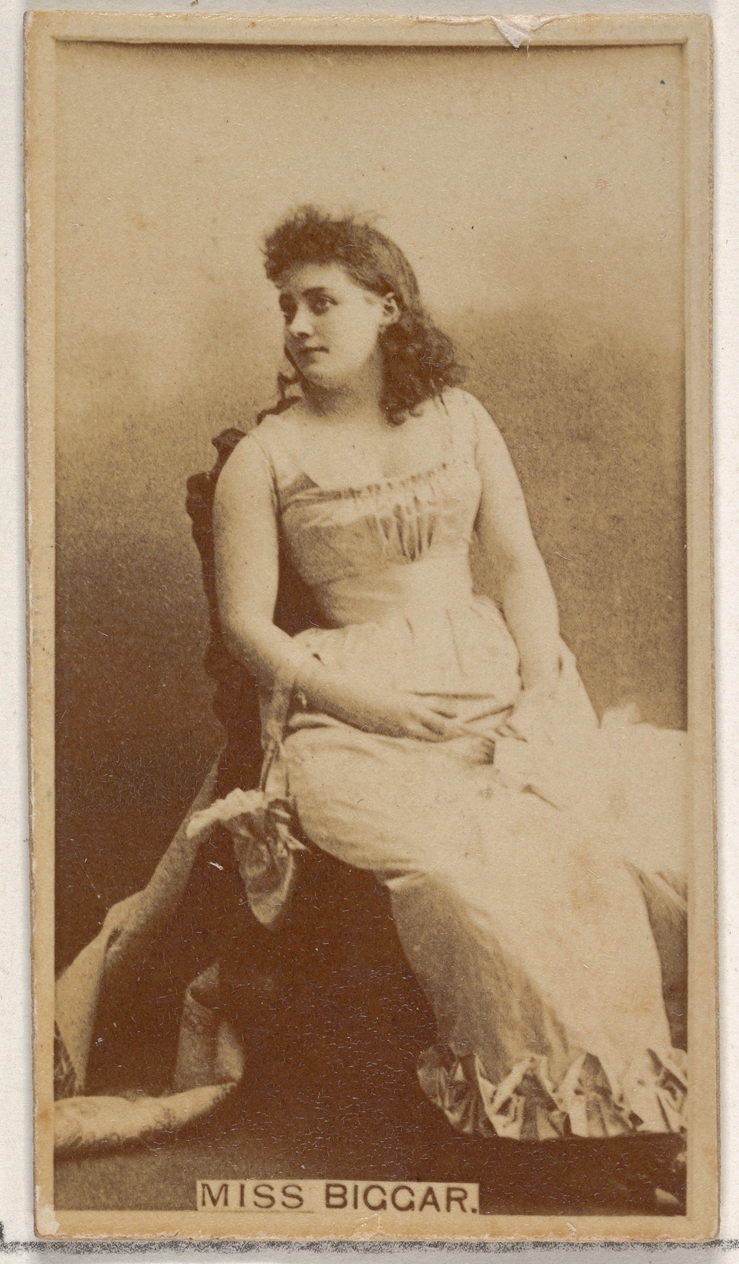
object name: photograph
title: Miss Laura Biggar, from the Actors and Actresses series (N45, Type 8) for Virginia Brights Cigarettes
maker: allen & ginter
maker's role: publisher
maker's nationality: american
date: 1888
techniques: albumen silver print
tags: portraits,women,actresses